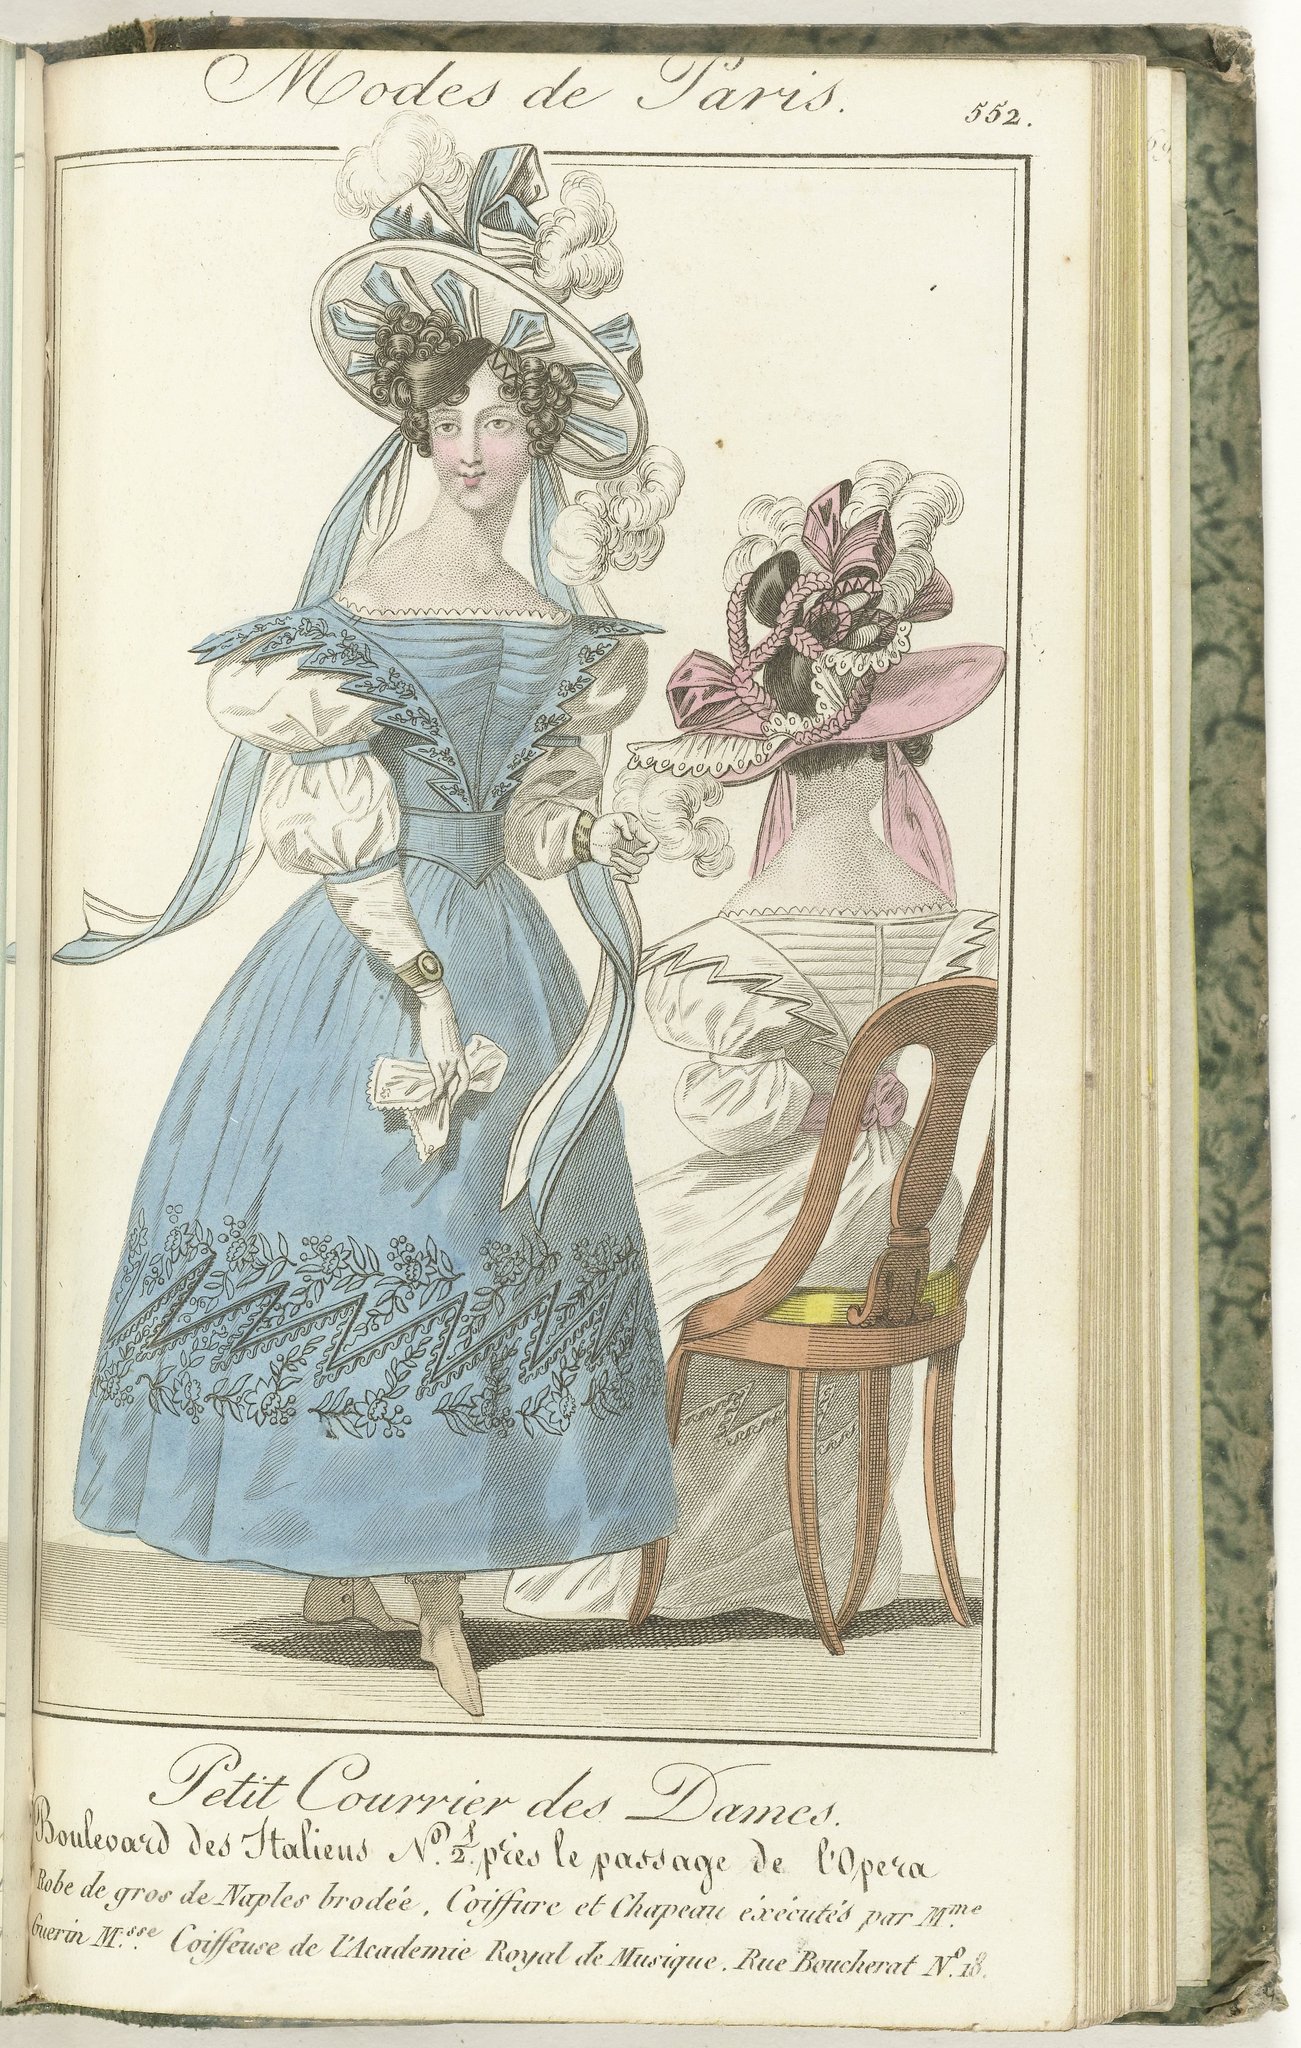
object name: fashion print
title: Petit Courrier des Dames, 5 mai 1828, No. 552 : Robe de gros de Naples brodée...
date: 1828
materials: paper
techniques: engraving, hand coloring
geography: paris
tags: handkerchief (+ women's clothes), embroidery (ornamentation) (+ women's clothes), styles of hairdress - aa - ~ women, fashion plates, head-gear: hat (+ women's clothes), dress, gown (+ women's clothes)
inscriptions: title: ‘Petit Courrier des Dames.’, title: ‘Modes de Paris.’, caption: ‘Robe de gros de Naples brodée, Coiffure et Chapeau éxécutés par M.me Guerin M.sse Coiffeuse de L'Academie Royal de Musique. Rue Boucherat No. 18’, address: ‘Boulevard des Italiens No.2 près le passage de l'Opèra.’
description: Staande vrouw in een japon van geborduurde gros de Naples. Coiffure en hoed van Guerin. Zakdoek in de hand. Dezelfde japon en hoed, op de rug gezien. Prent uit het modetijdschrift Petit Courrier des Dames (1821-1868). Ingebonden (met enkele pp. Le Journal des Dames et des Modes). 15 Januari 1827 t/m 20 maart 1830. Incompleet.